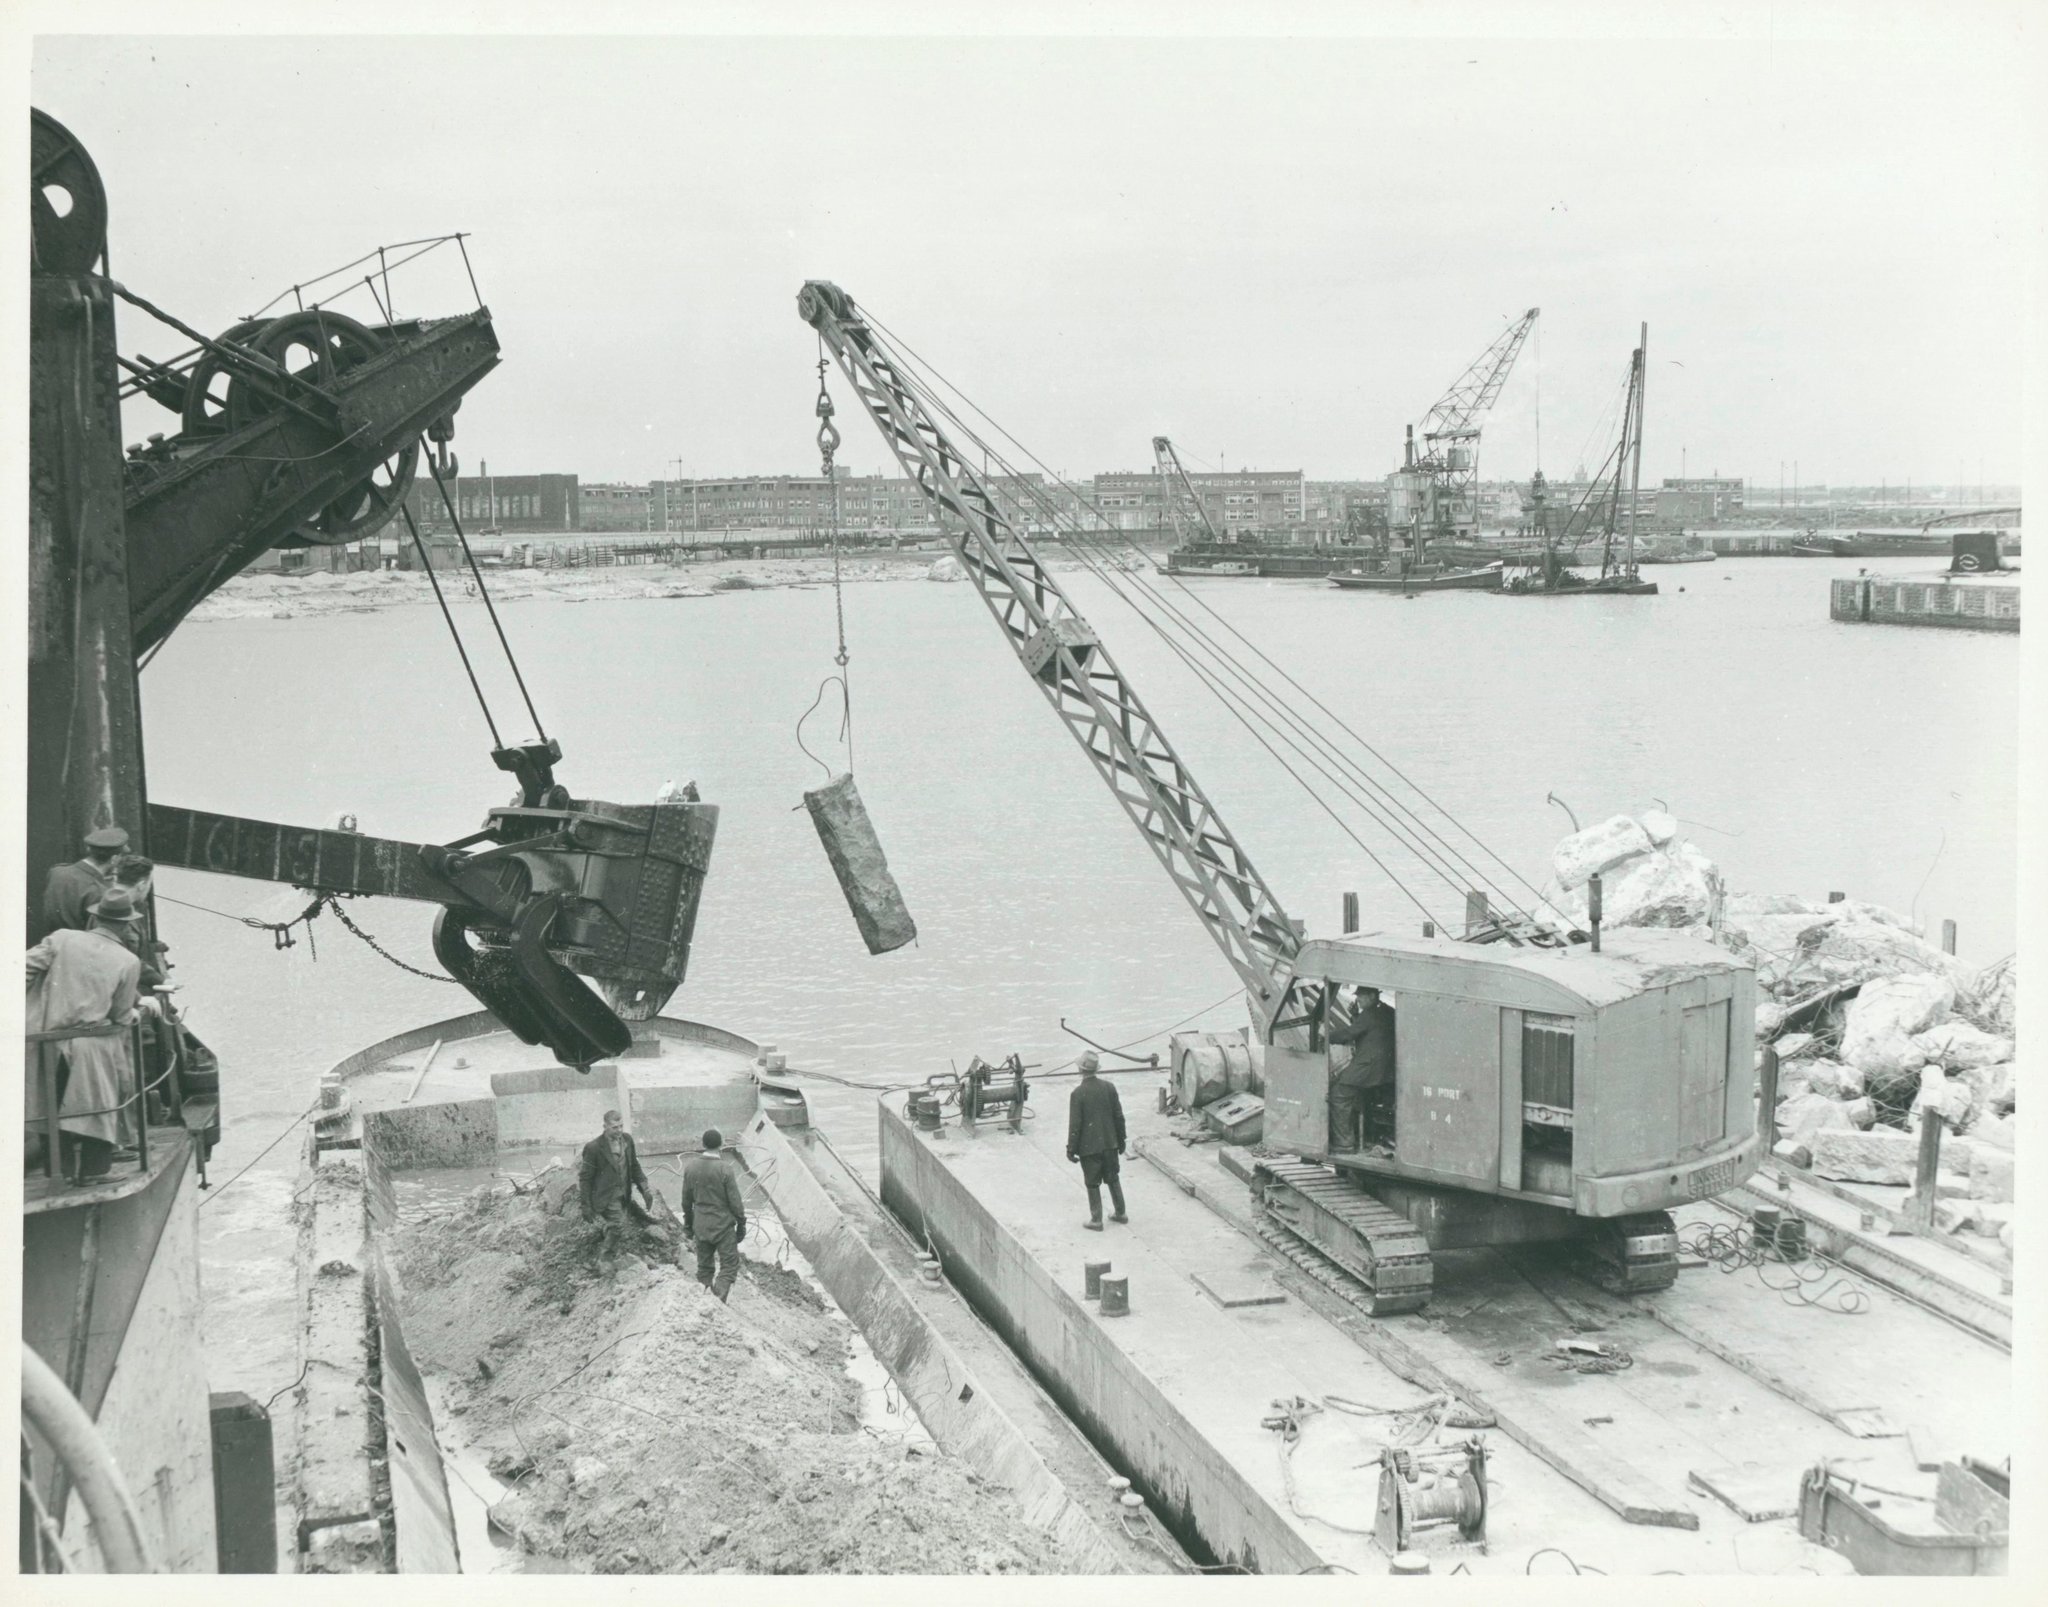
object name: documentary photograph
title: Hulp uit USA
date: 1946-1947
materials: photographic support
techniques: photography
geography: rotterdam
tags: rotterdam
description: Kranen uit de USA worden ingezet bij het herstel van de Rotterdamse haven. Deze kraan is aan de kade bezig met het ruimen van puin, met aan zijn linkerzijde een gereed liggende vrachtschip met zand en aan de rechterzijde een grote hoeveelheid puin. Tegen de achtergrond van de rivier en daarachter aan de horizon een woonwijk.